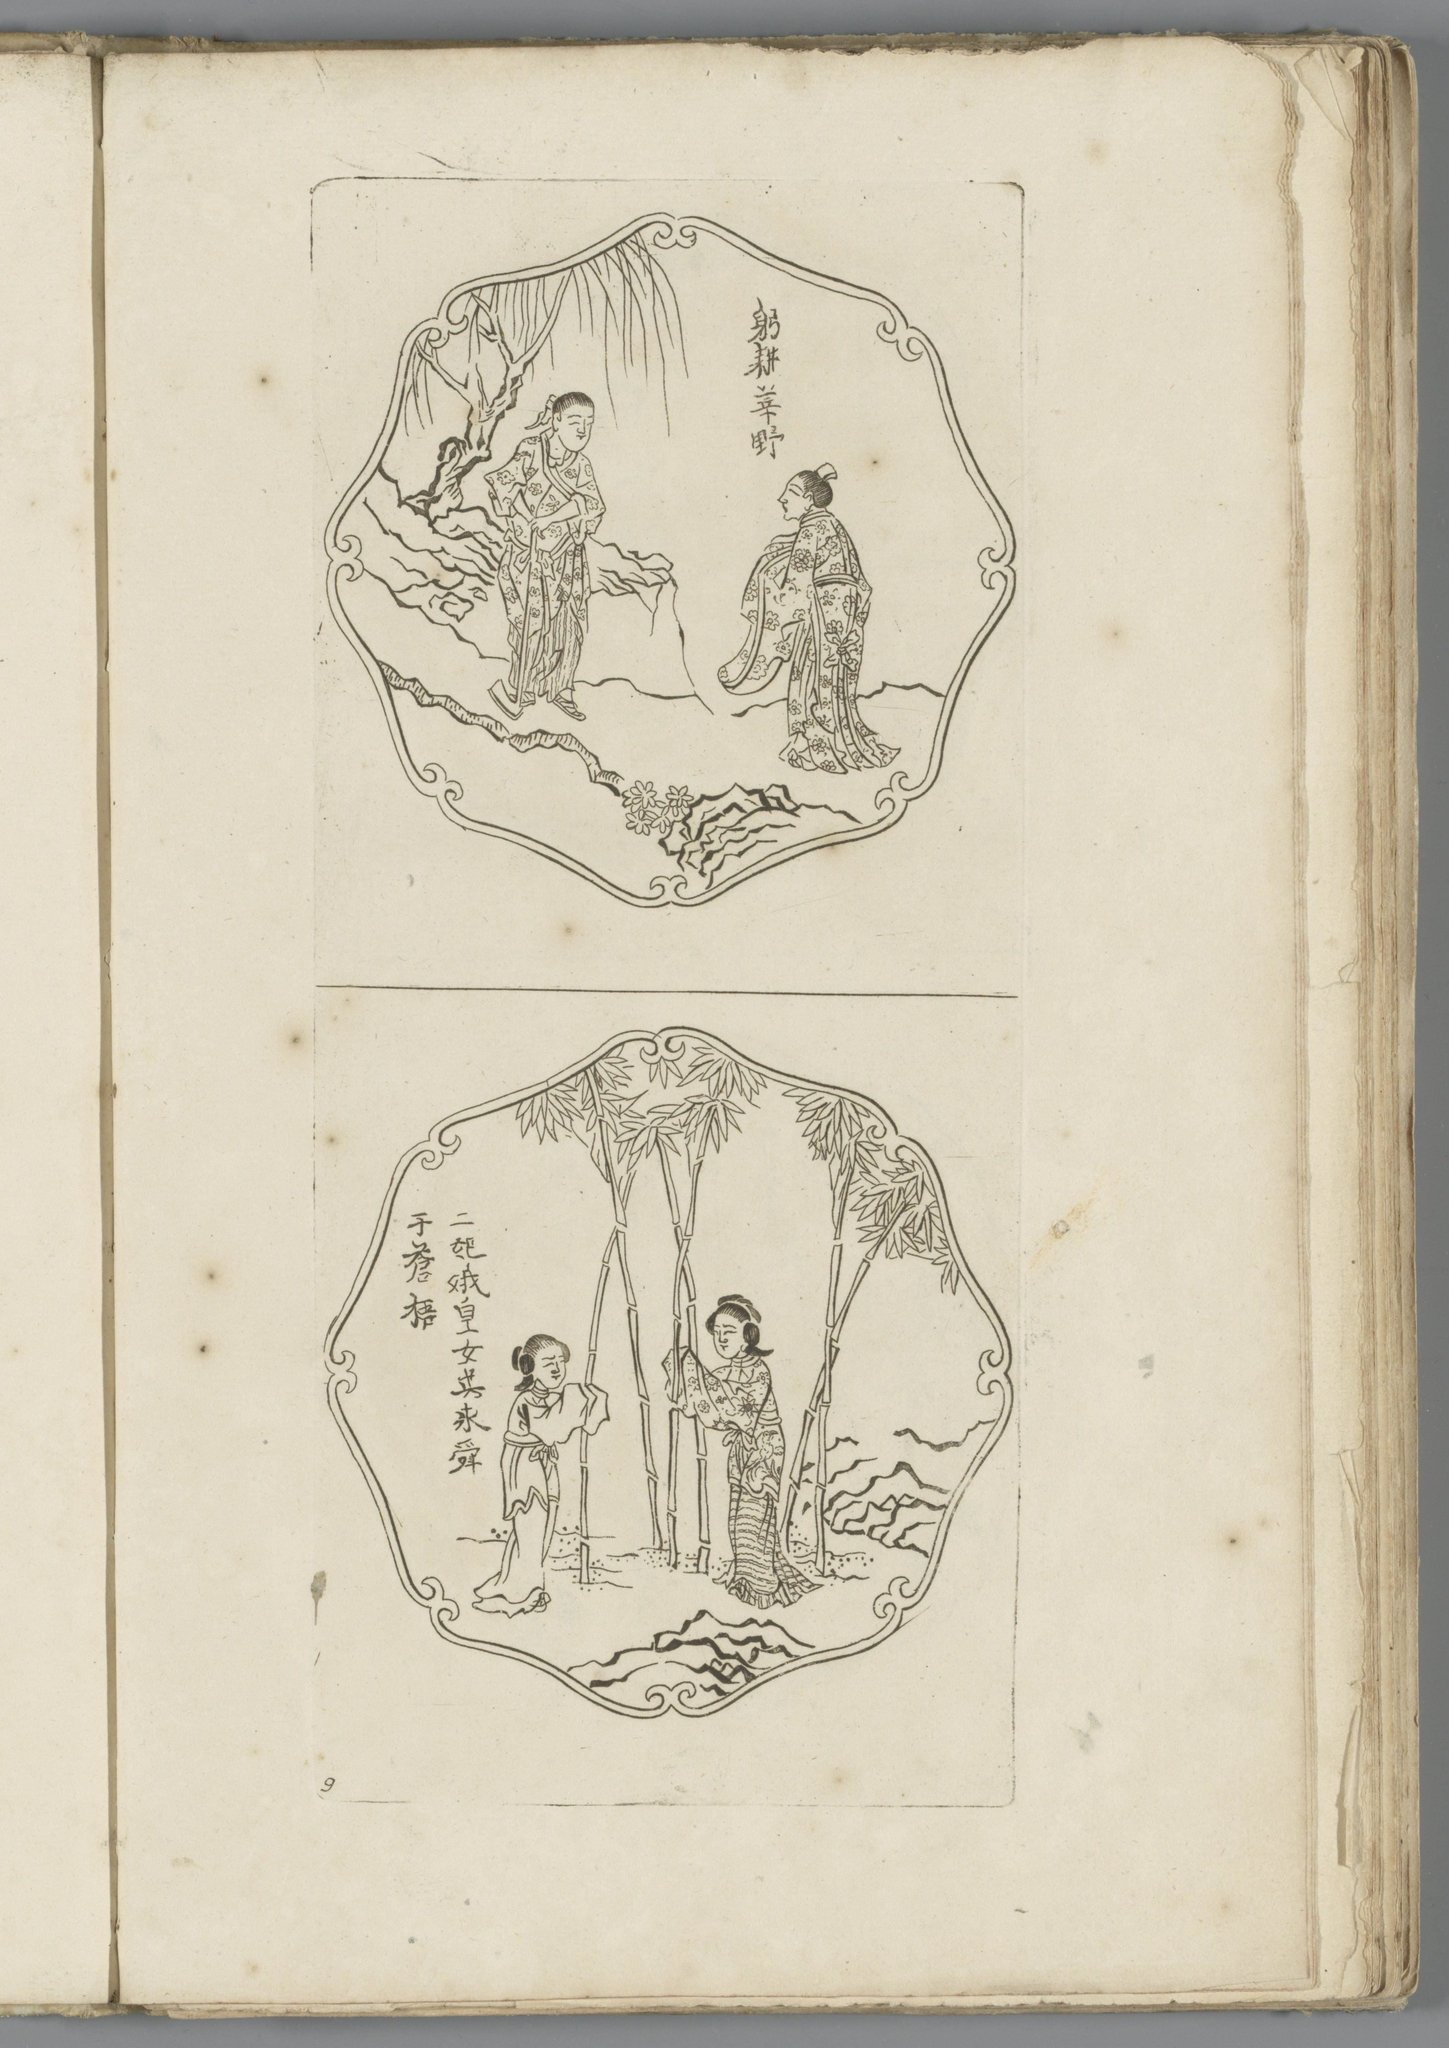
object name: album leaf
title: Picturae Sinicae Ac Surattenae, Vasis Tabellisque exhibitae, Admiranda; colligente Petro Schenkio cum privil: Amstelaed: 1702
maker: pieter schenk (i)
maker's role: print maker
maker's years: 1660-1711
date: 1702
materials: paper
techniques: etching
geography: amsterdam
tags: weeding, chinese